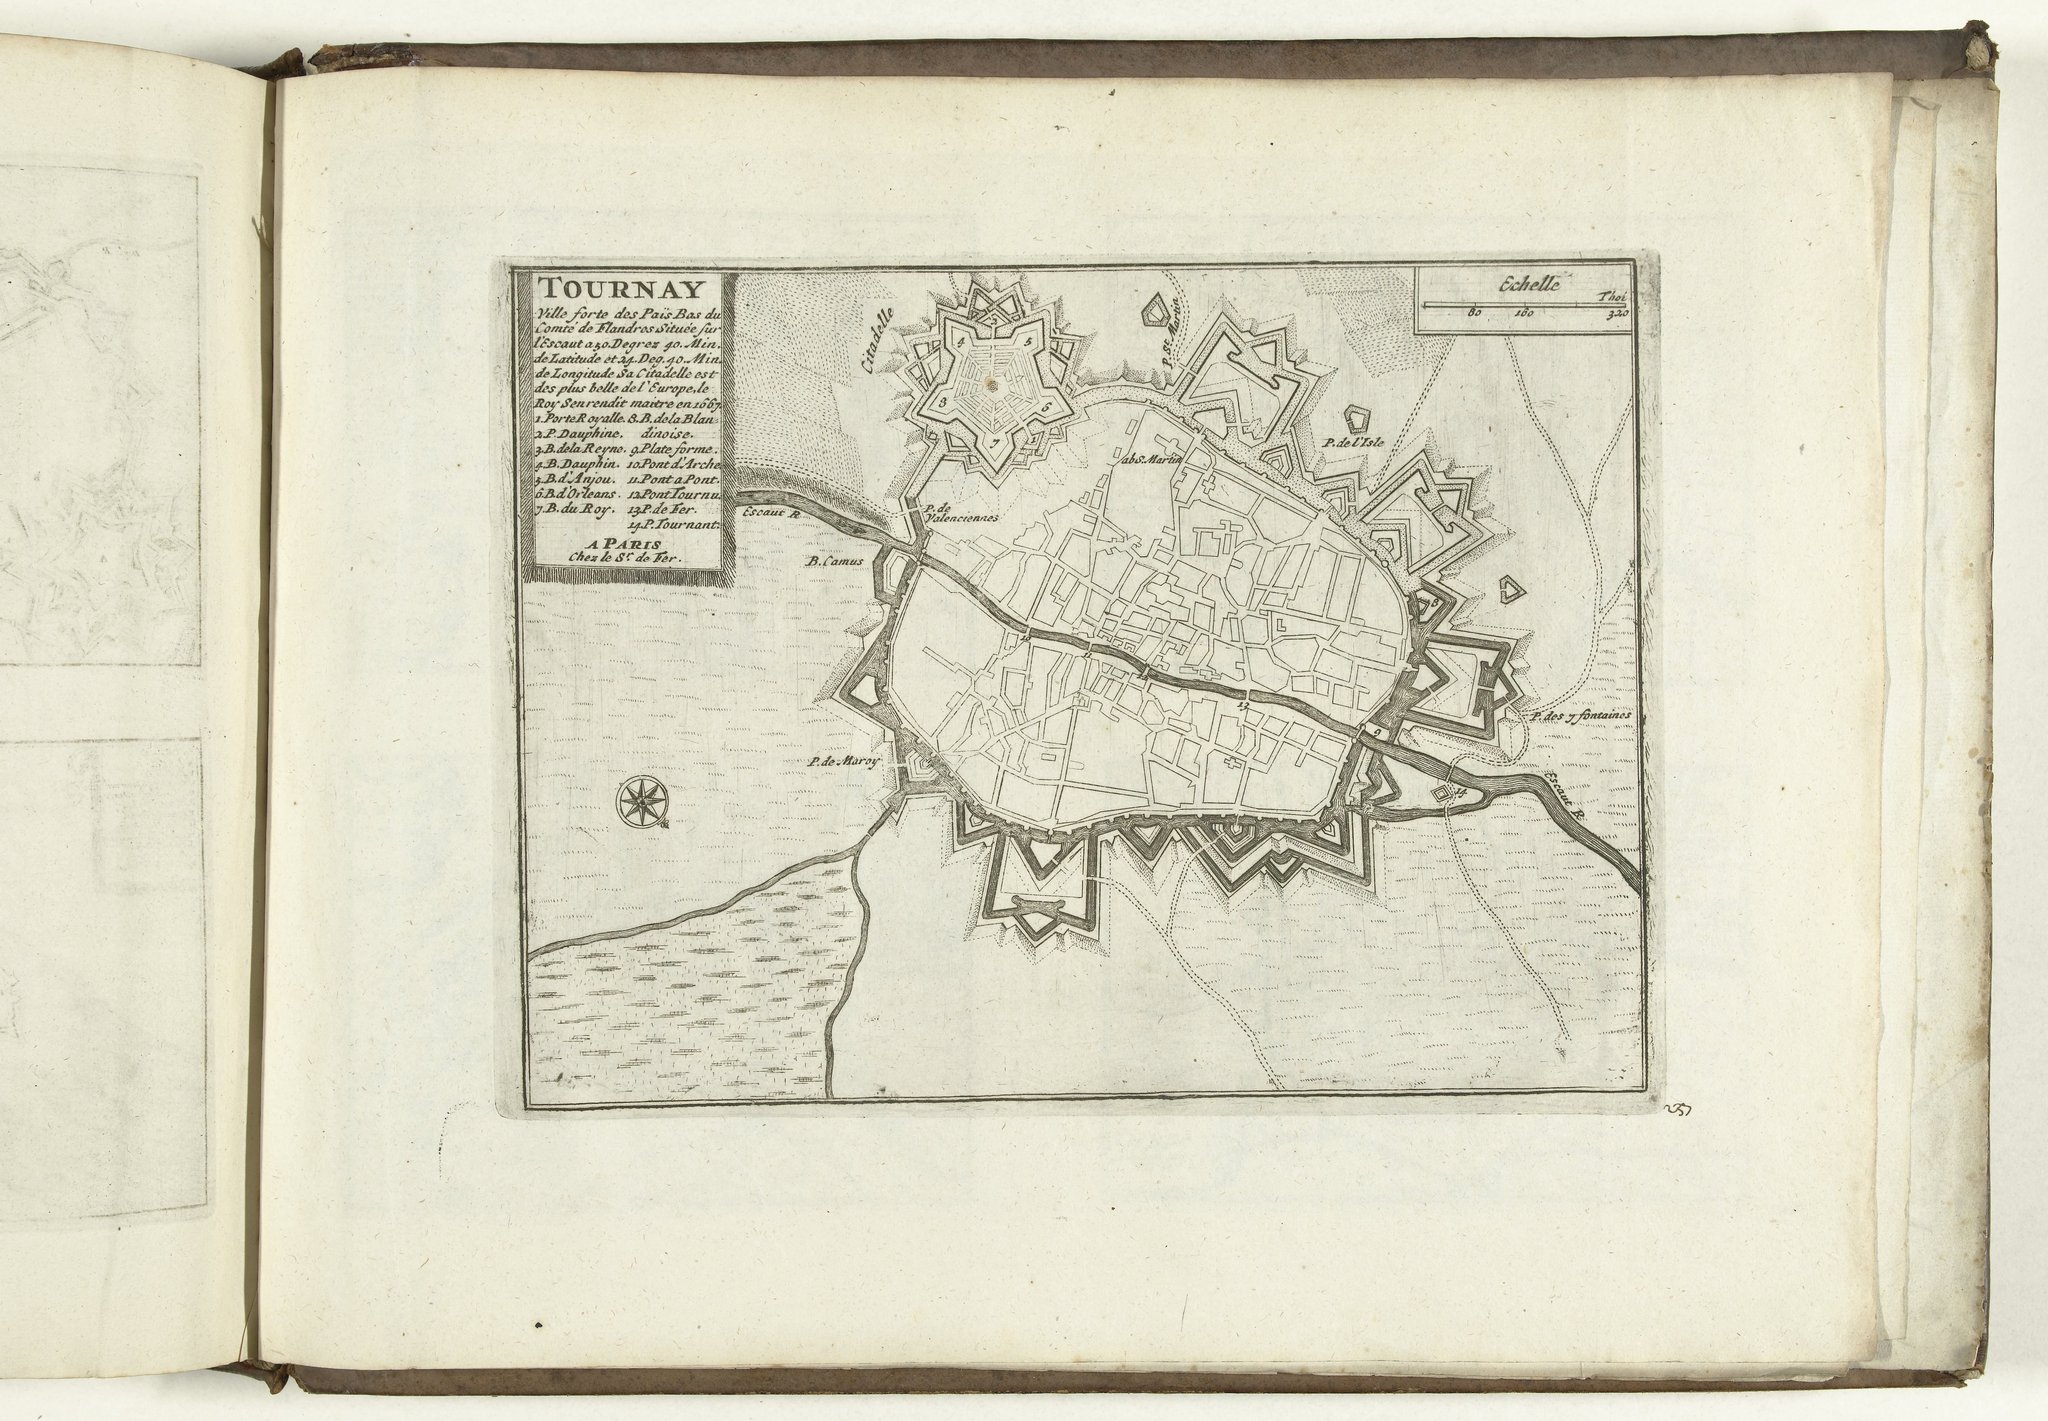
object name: print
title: Tournay Ville forte des Pais Bas du Comté de Flandres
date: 1726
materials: paper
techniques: etching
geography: northern netherlands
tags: fortress, maps of cities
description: Plattegrond van de verdedigingswerken om de stad Tournai (Doornik). Plaat nr. 237 in deel X van het prentwerk: Les Forces de l'Europe, Asie, Afrique et Amerique ... Comme aussi les Cartes des Côtes de France et d'Espagne uit 1726, dit eerste deel met 238 met de hand genummerde platen van vermaarde sterke steden en vestingen in het kader van de Spaanse Successieoorlog 1701-1713. Voor het merendeel zijn deze platen gekopieerd naar de anonieme Franse platen van vermaarde sterke steden en vestingen: in Les forces de l'Europe en in: Le theatre de la guerre, dans les Pays-Bas, beide oorspronkelijk uitgegeven door Nicolas de Fer te Parijs (1693-1697) in het kader van de Negenjarige Oorlog. Titel en opschriften in het Frans. Rechtsonder sporen van het weggepolijste nummer: 75.